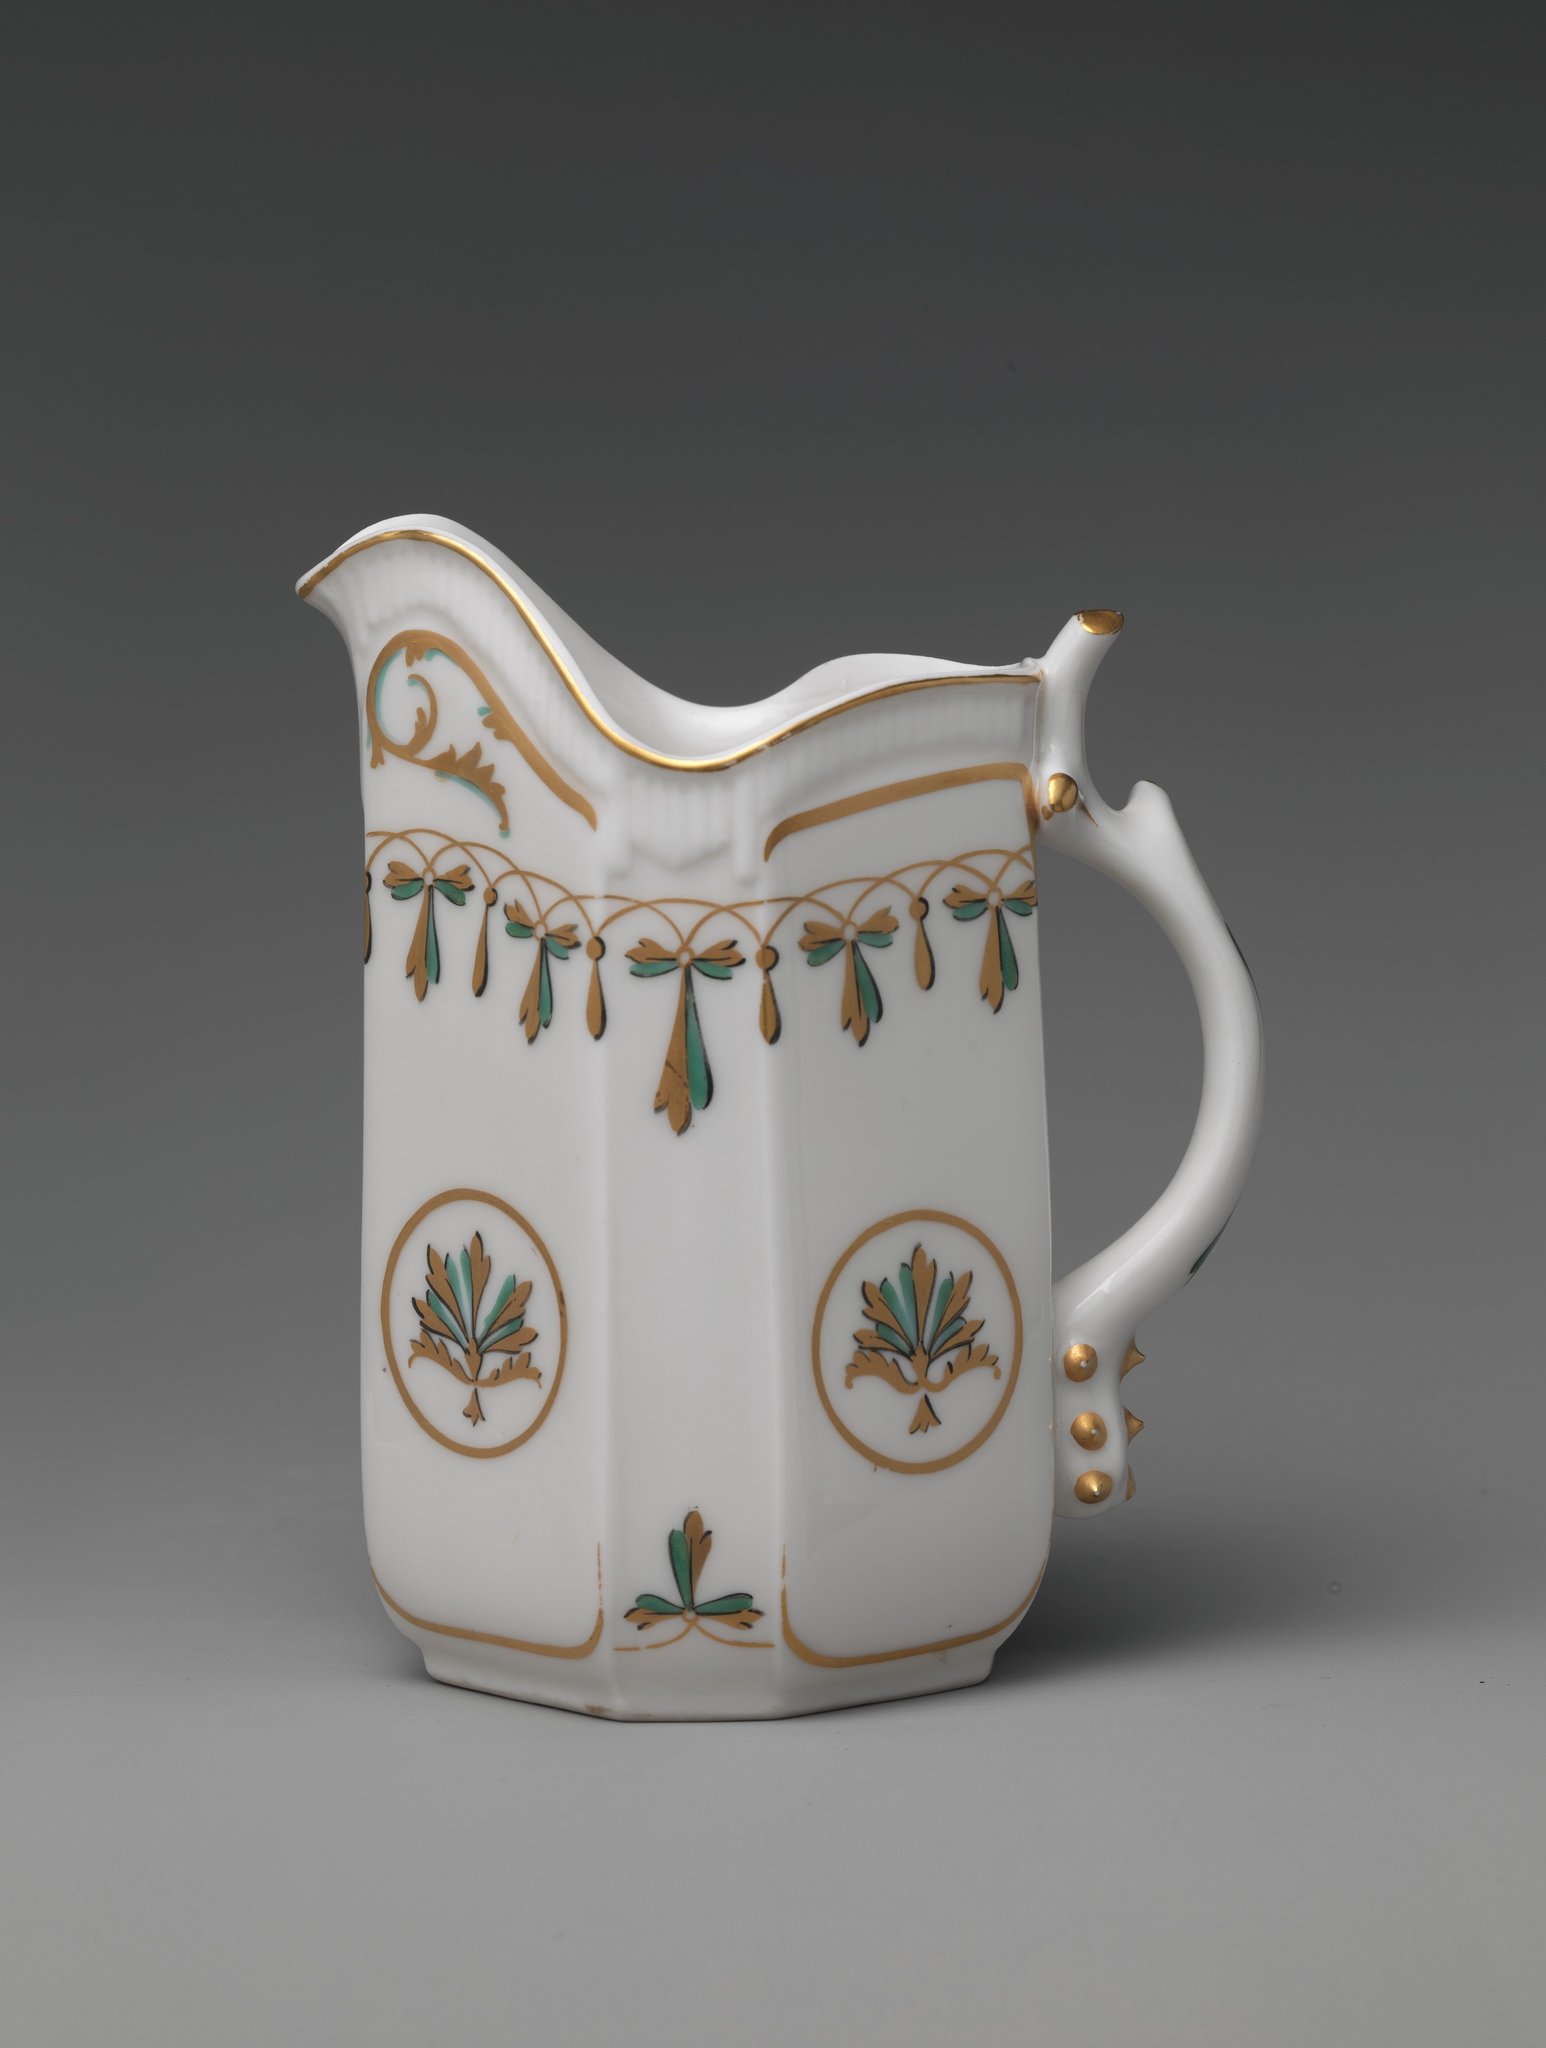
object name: cream pitcher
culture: american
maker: union porcelain works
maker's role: maker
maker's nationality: american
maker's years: 1863-1922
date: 1887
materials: porcelain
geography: united states